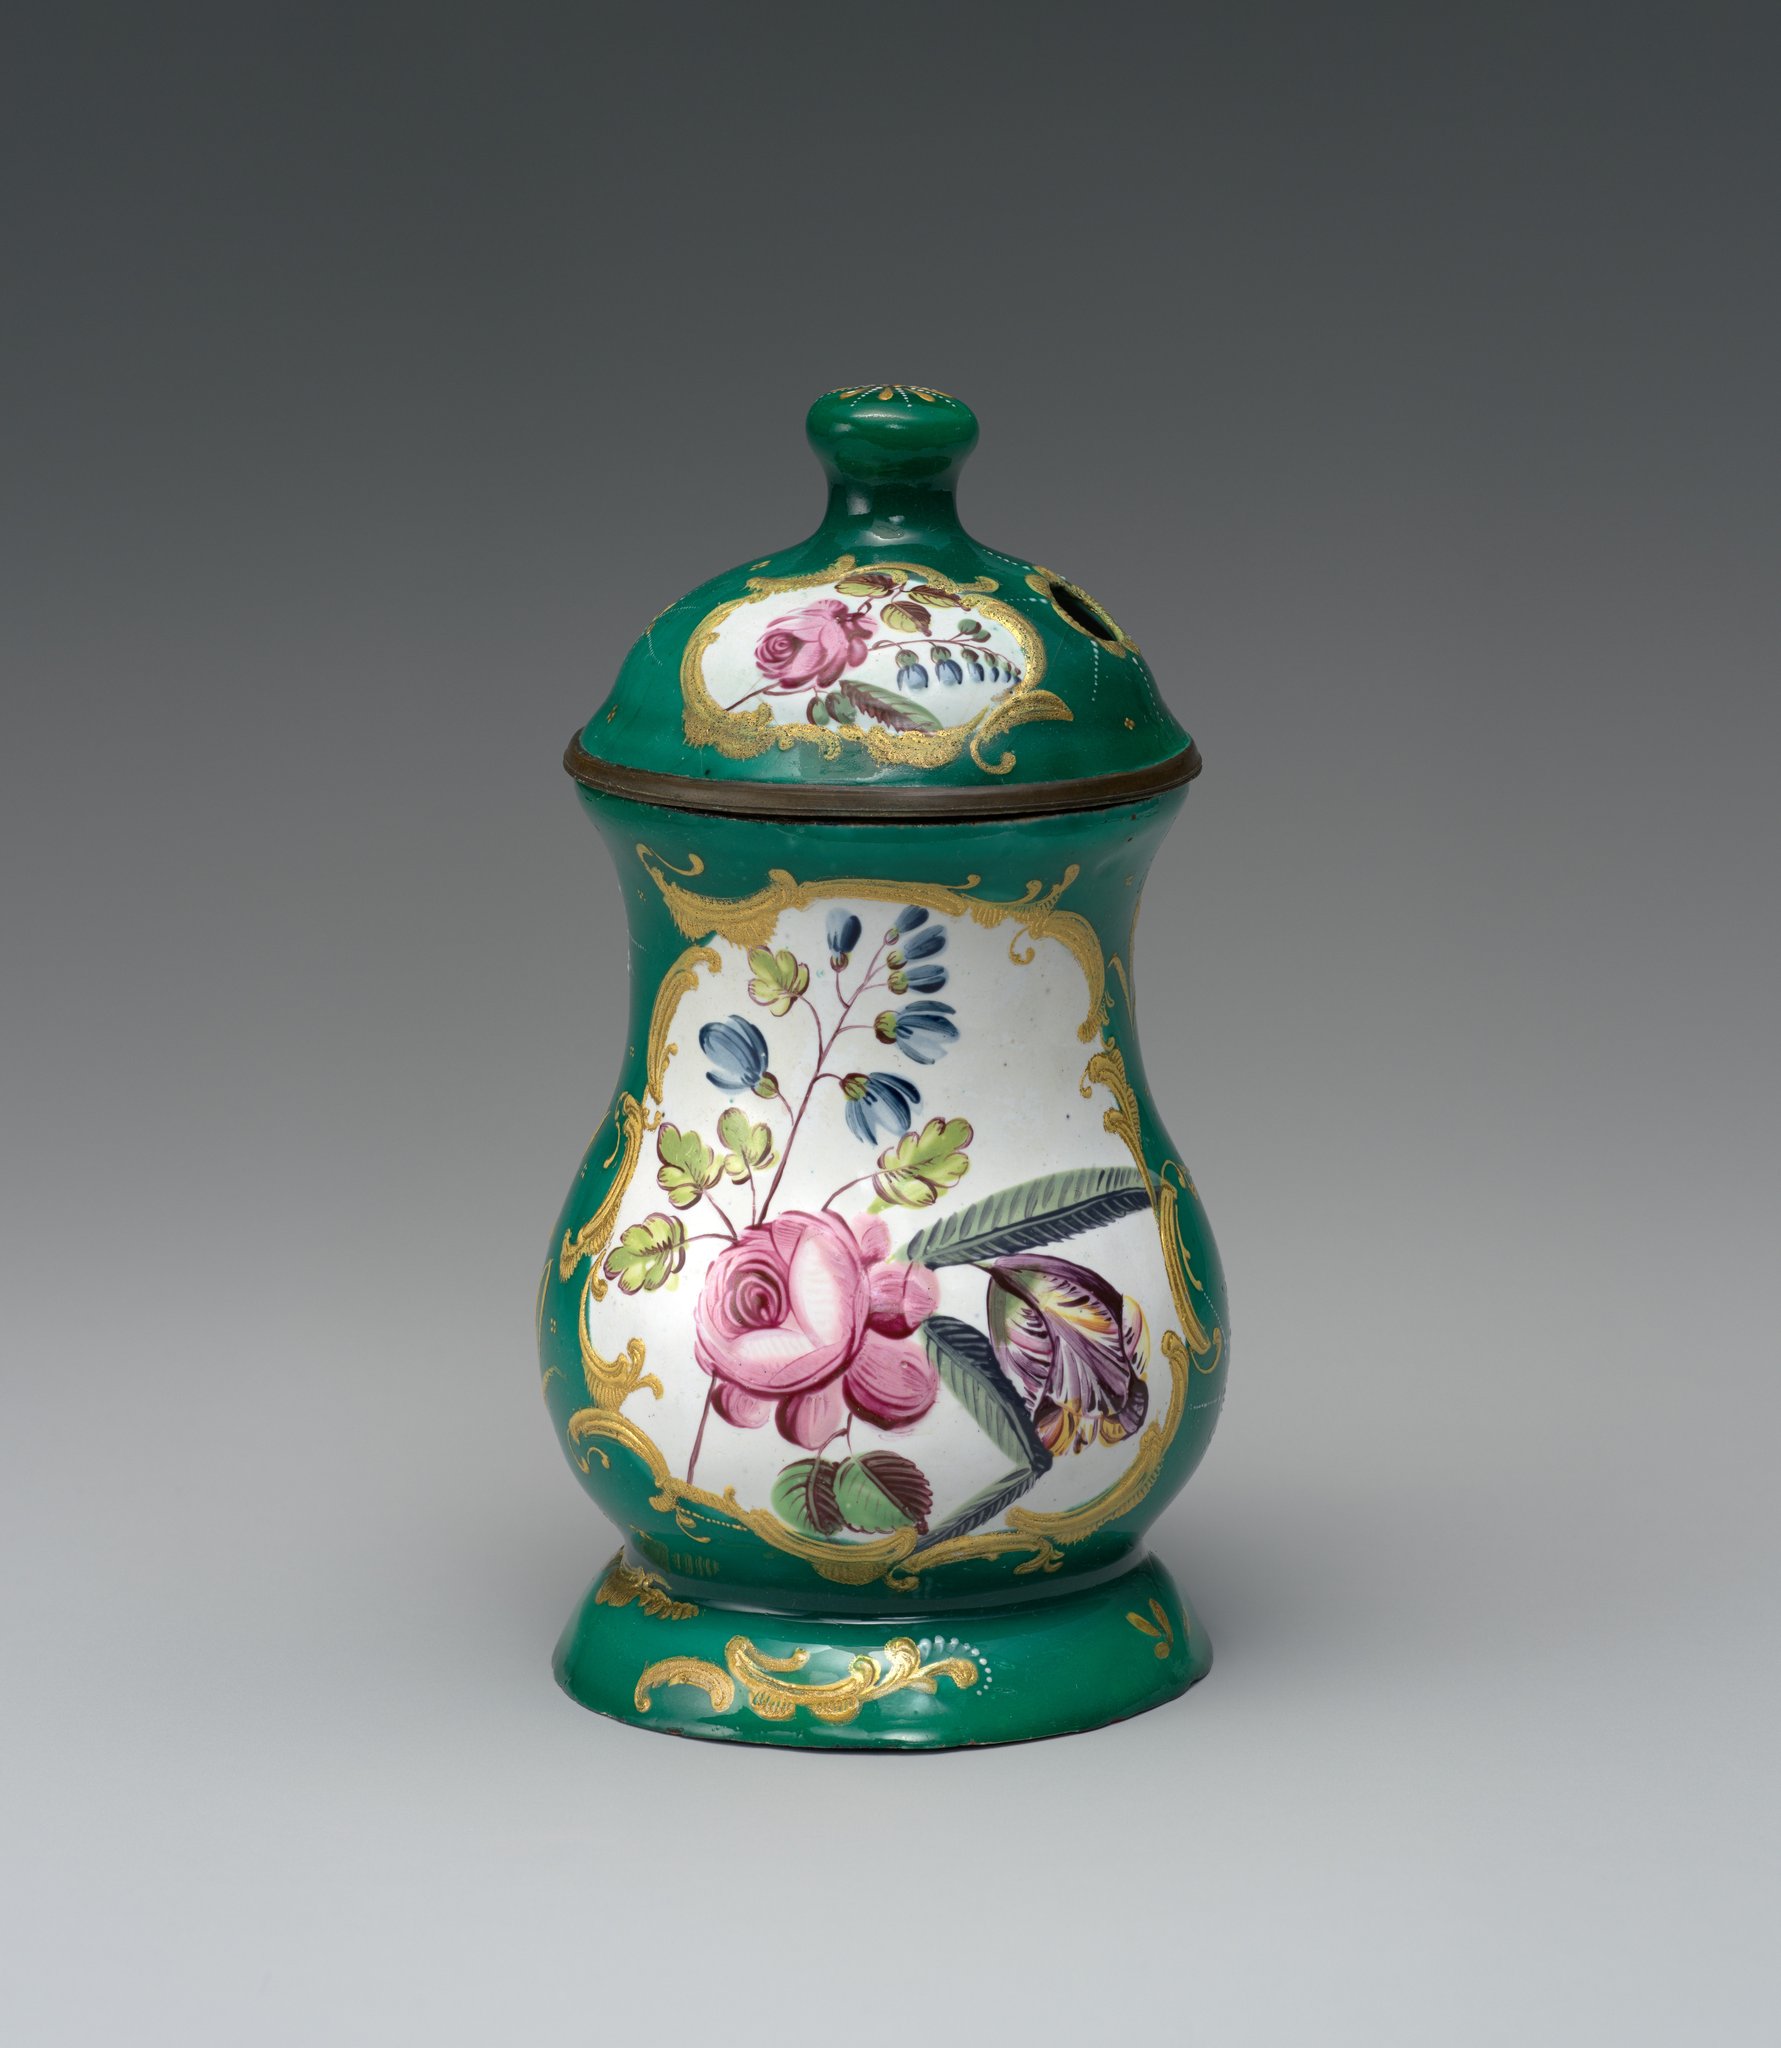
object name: mustard pot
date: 1770-1780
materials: copper, enamel